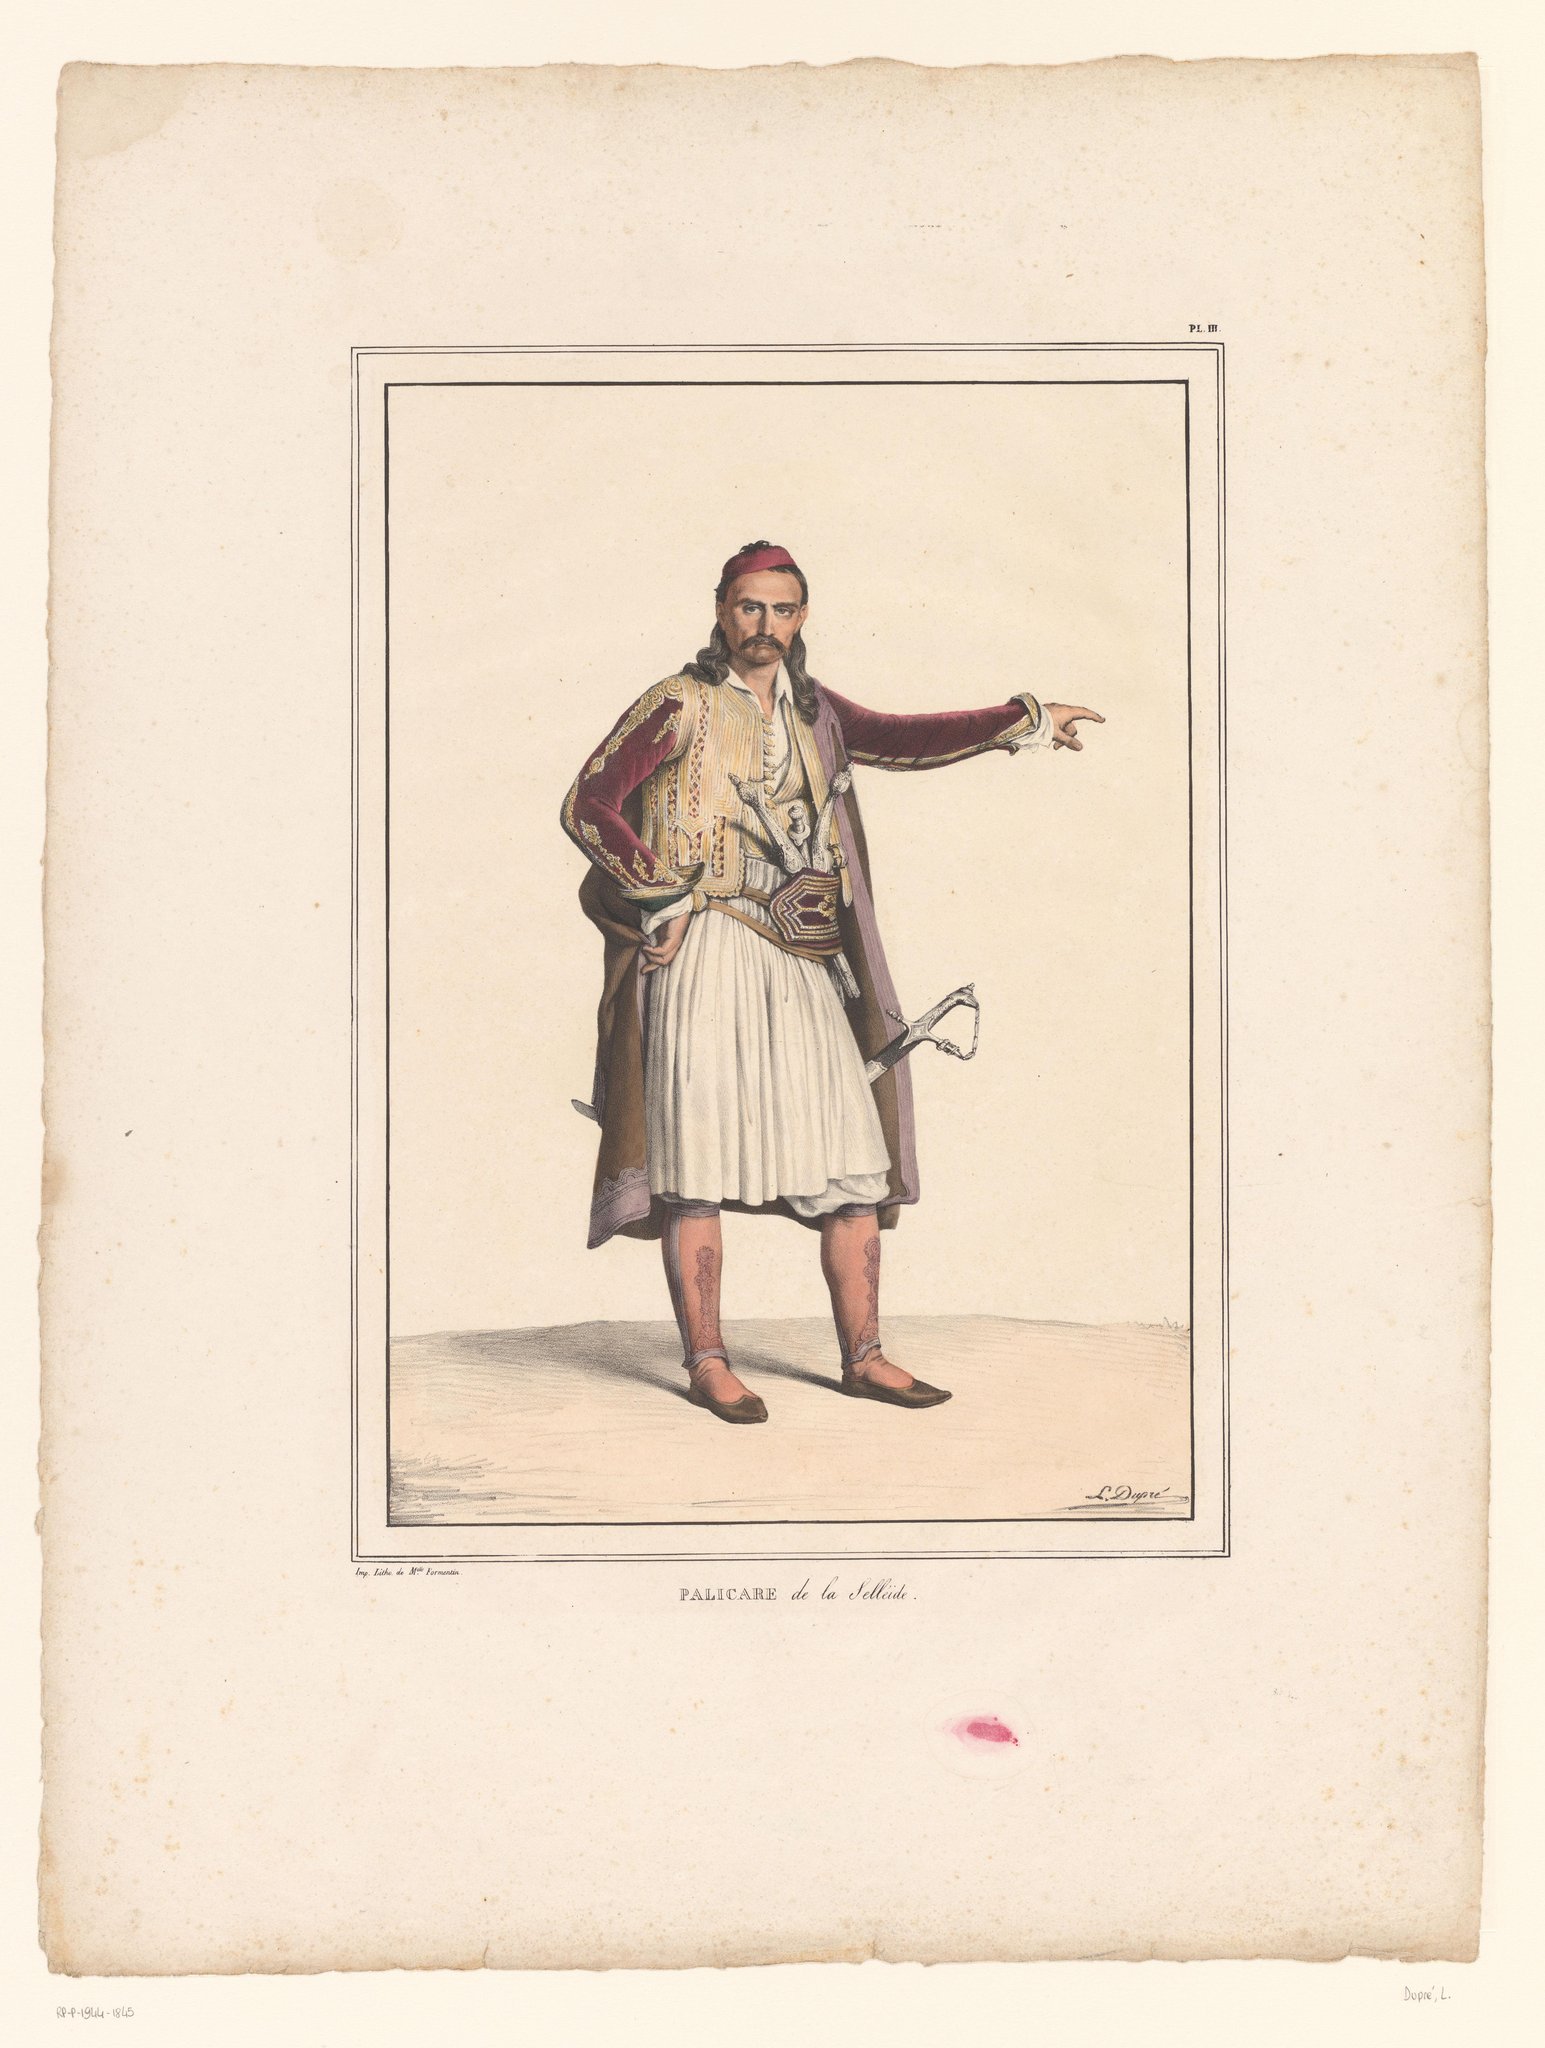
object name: print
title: Voyage à Athènes et à Constantinople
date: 1825-1839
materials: paper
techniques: hand coloring, lithograph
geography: paris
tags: anonymous historical person portrayed, the soldier; the soldier's life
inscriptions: watermark: ‘103’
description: Palikares waren Griekse en Albanese huurlingen in dienst van Ottomaanse pasja's. De prent maakt deel uit van de serie 'Voyage à Athènes et à Constantinople ou collection de portraits, de vues et de costumes Grecs et Ottomans' die tussen 1825 en 1839 in tien delen van vier prenten werd uitgebracht. De in totaal veertig prenten dienden samen met een tekst van 52 pagina's voorzien van vignettes als een verslag van de reis die Louis Dupré in 1819 naar Athene en het huidige Istanboel maakte (zie documentatie).